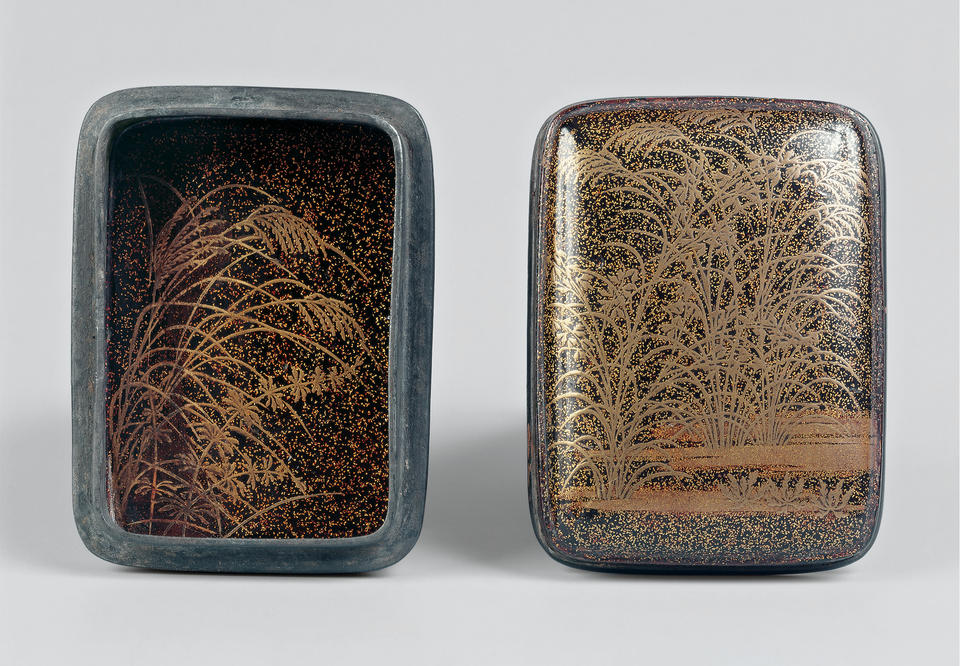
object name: incense box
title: Incense Box (Kogo) with Design of Autumn Grasses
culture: japanese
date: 1401-1500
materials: gold, lacquer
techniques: maki